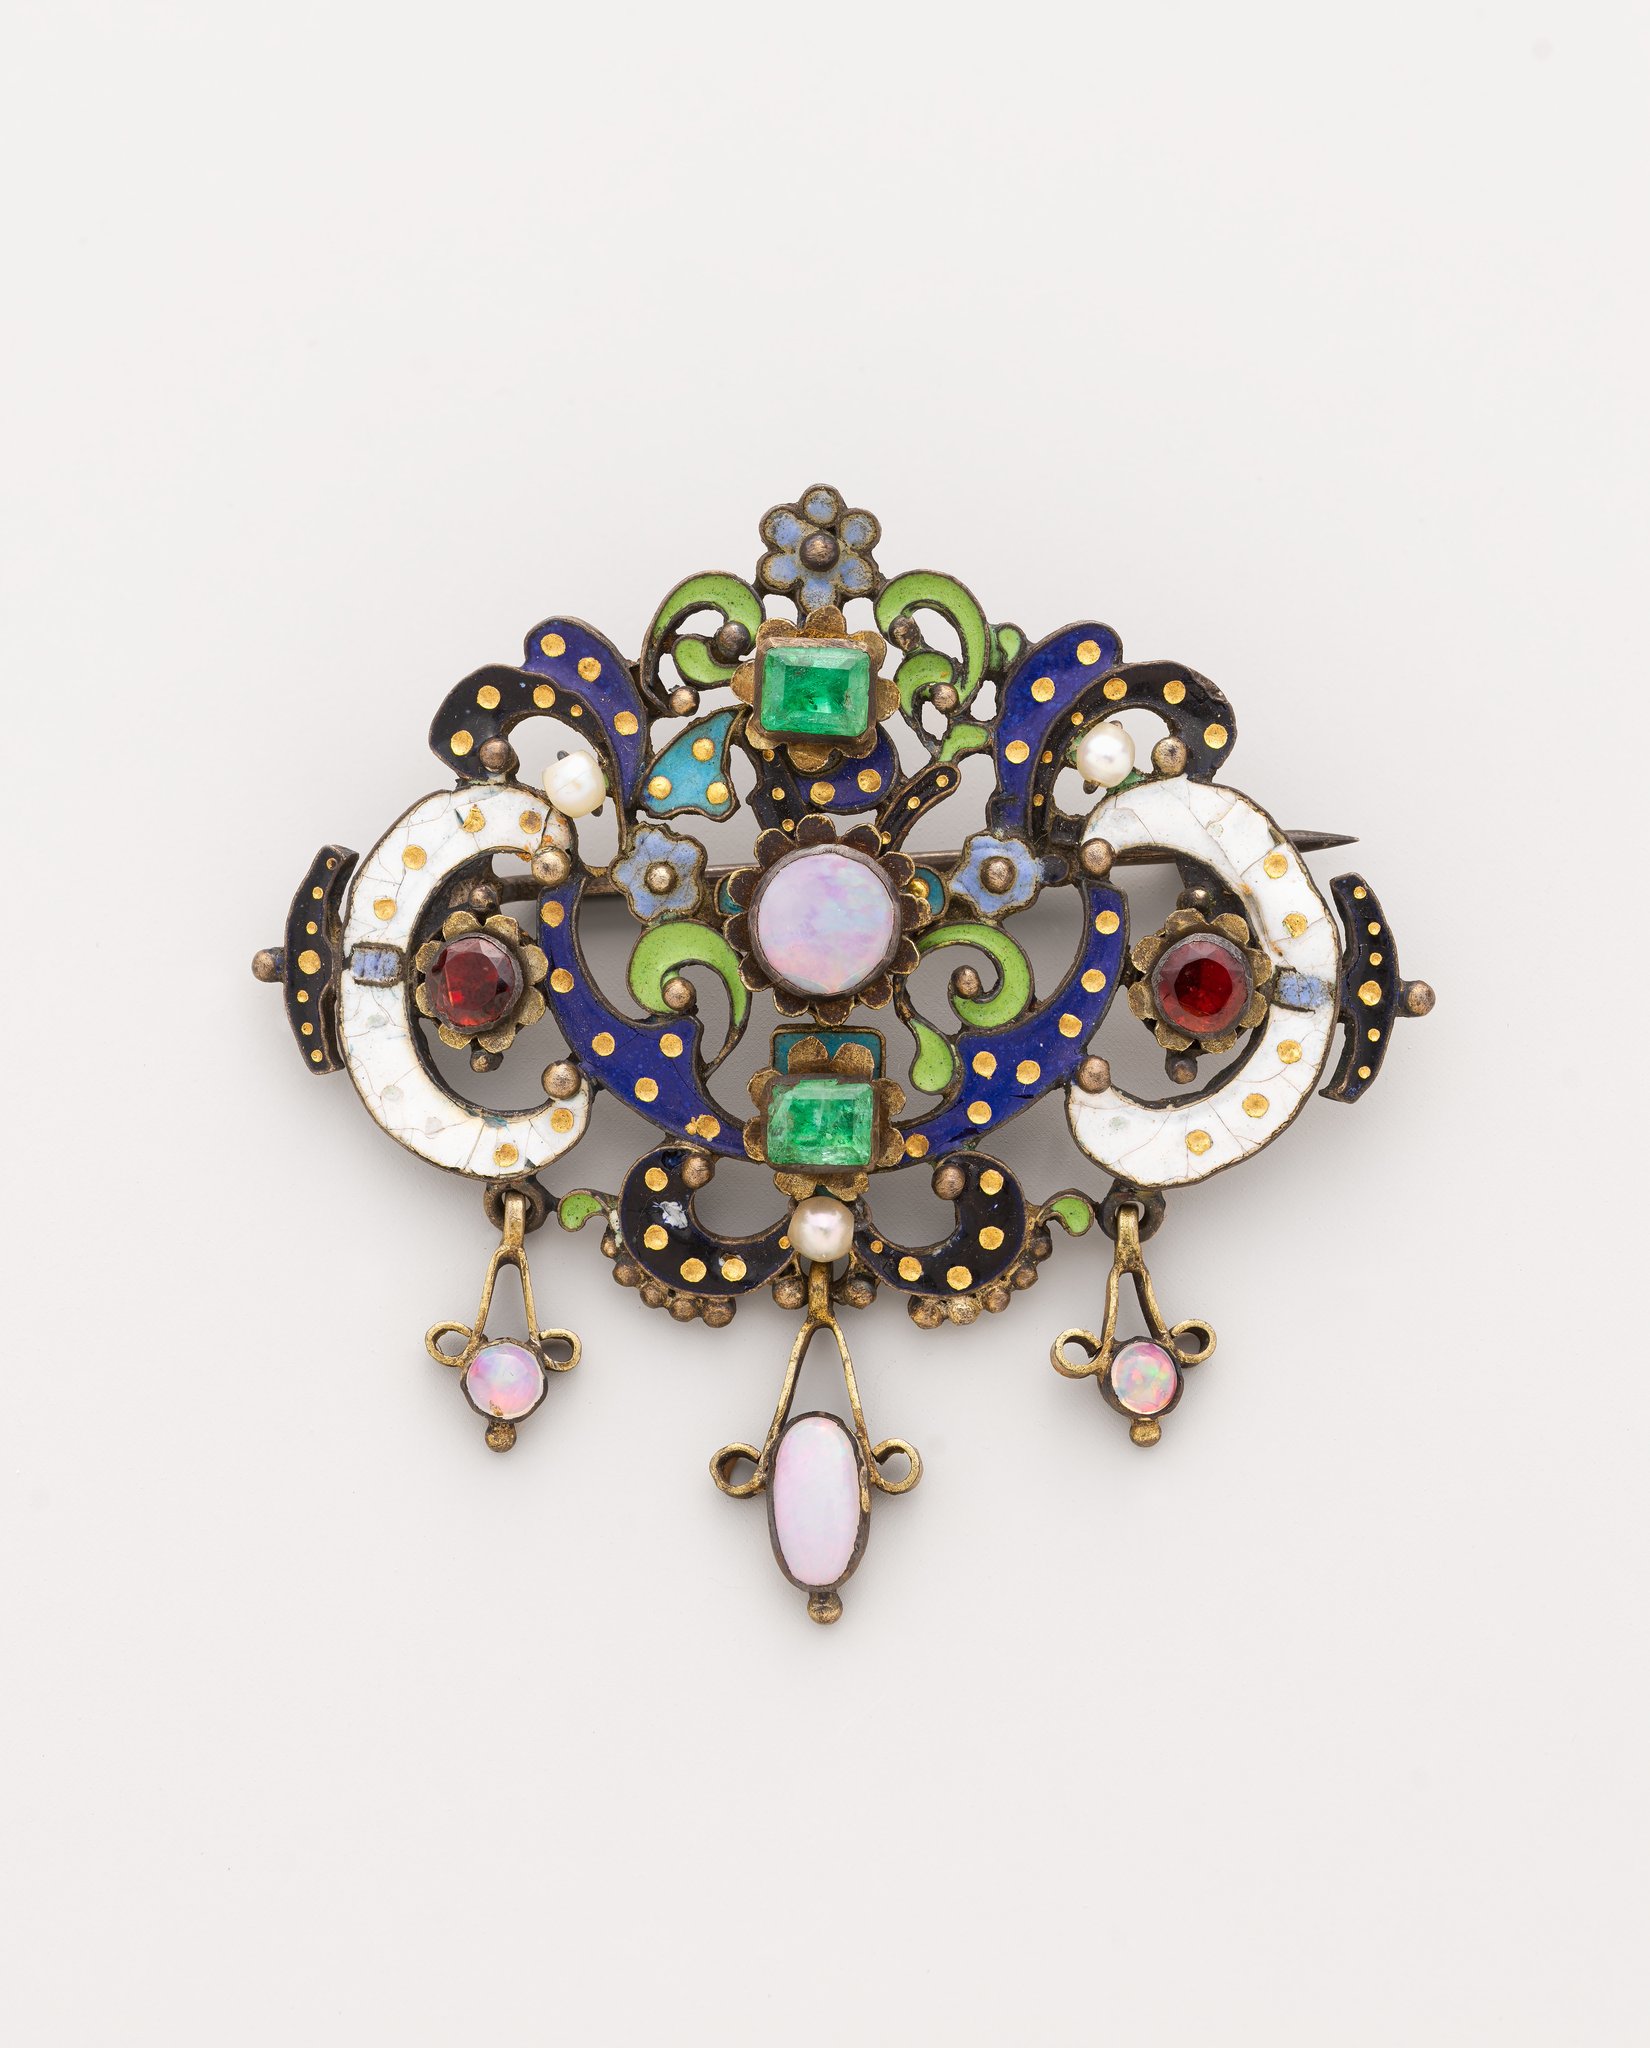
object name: clasp or brooch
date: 1801-1900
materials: gemstone, enamel, garnet, pearl, silver gilt